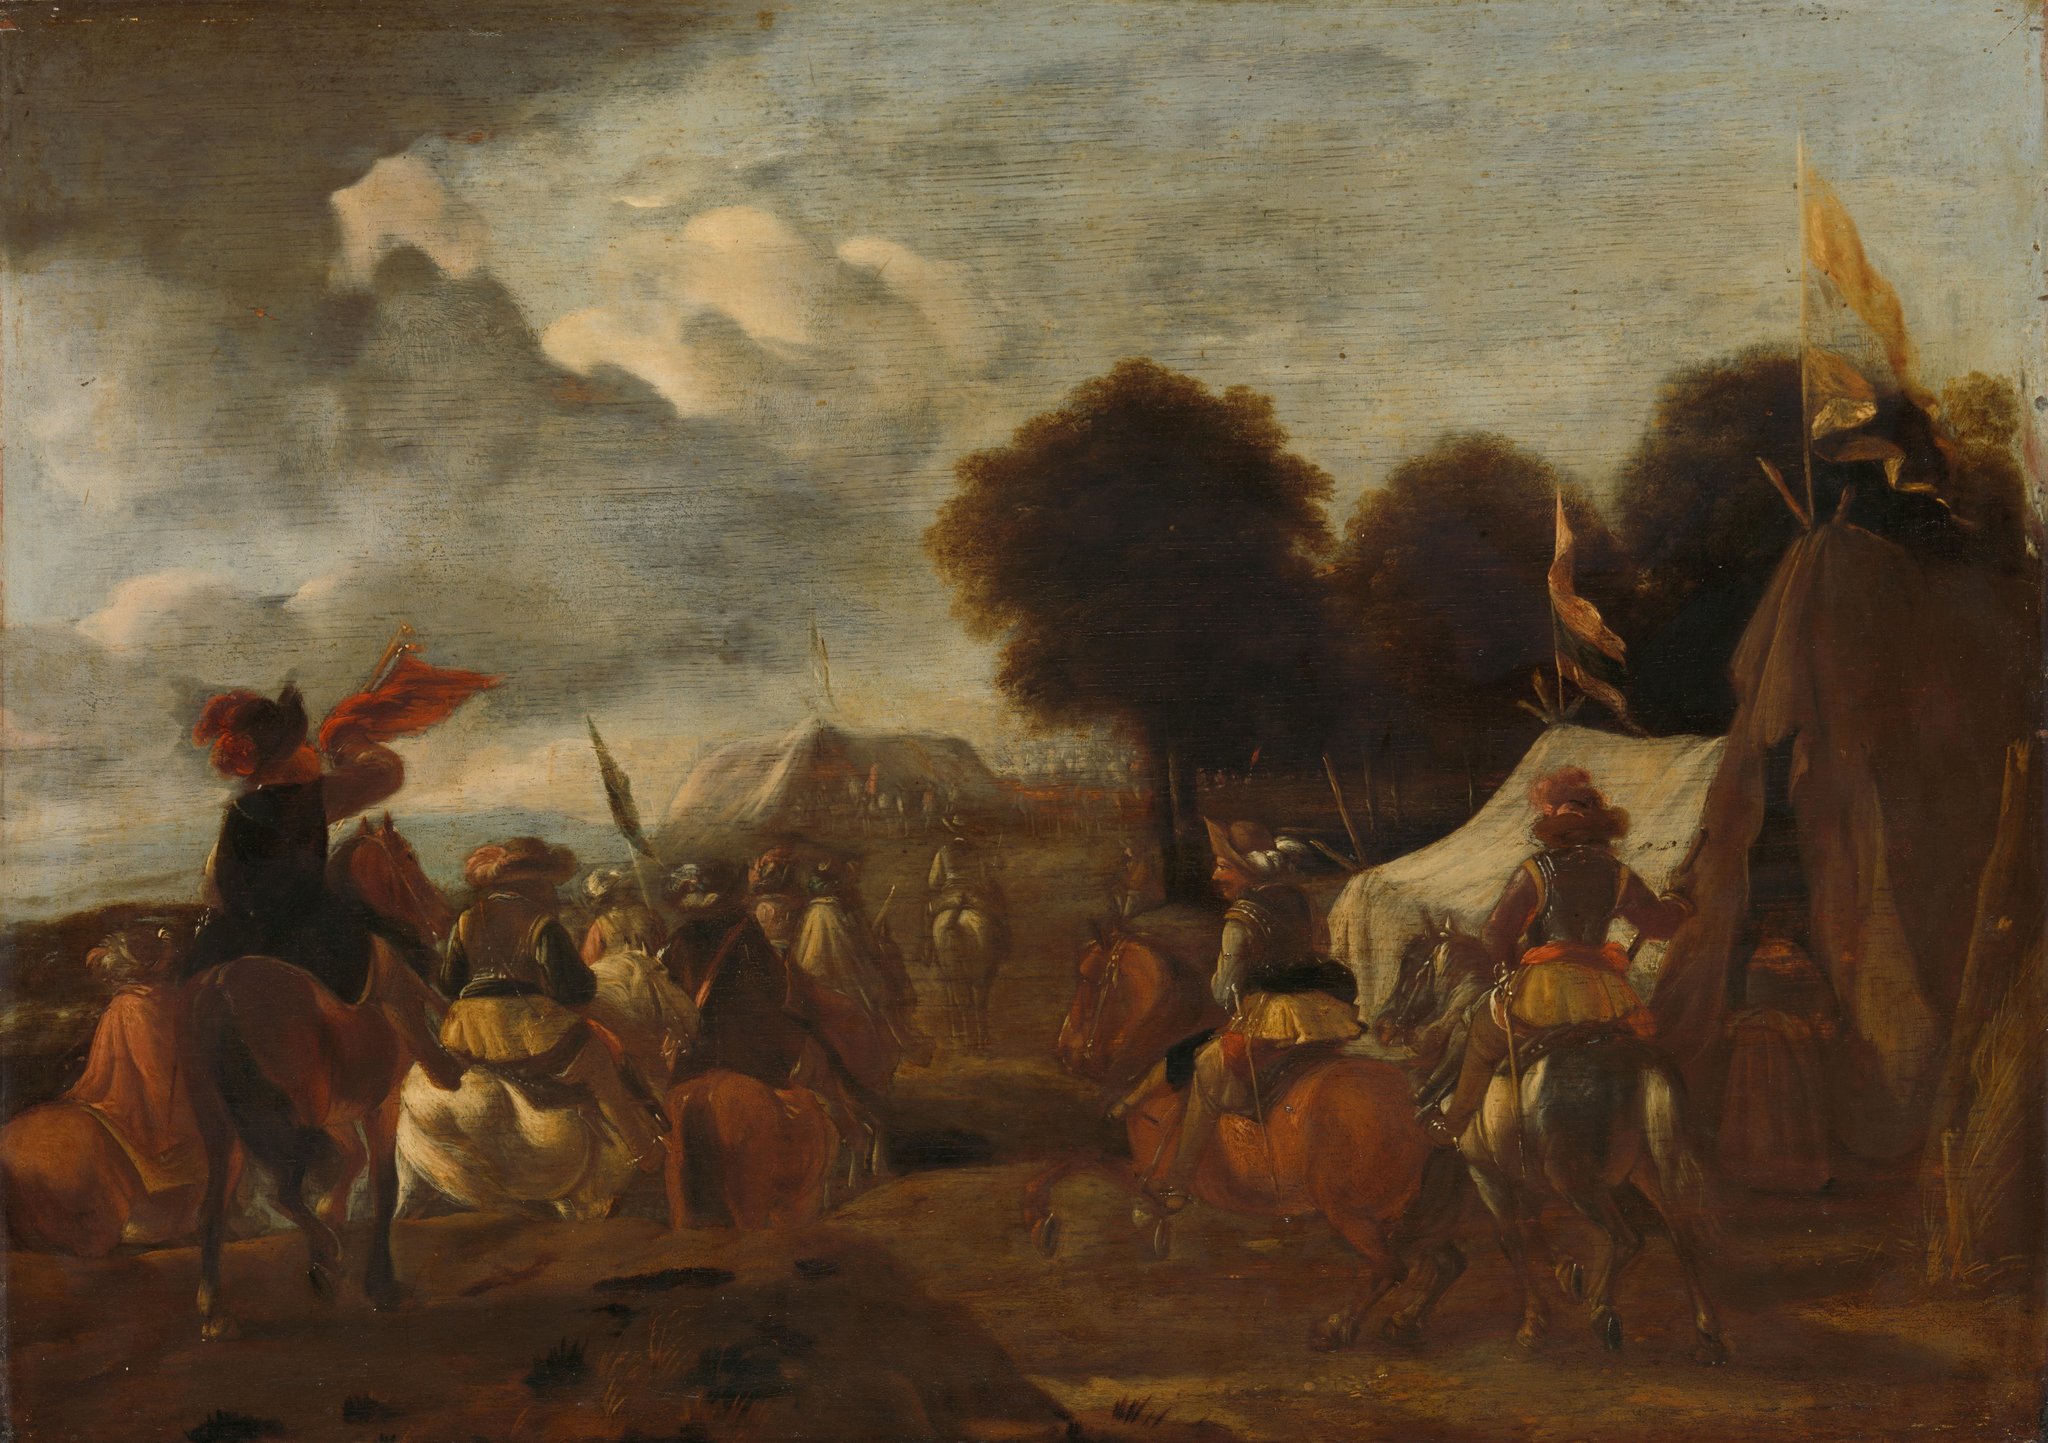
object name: painting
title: Army Camp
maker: Anonymous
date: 1625-1674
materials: oil, panel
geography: netherlands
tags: (military) camp with tents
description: Het legerkamp. Een groep ruiters rijdt door een legerkamp, links een trompetter. Rechts een vrouw in een tent met vaandel.